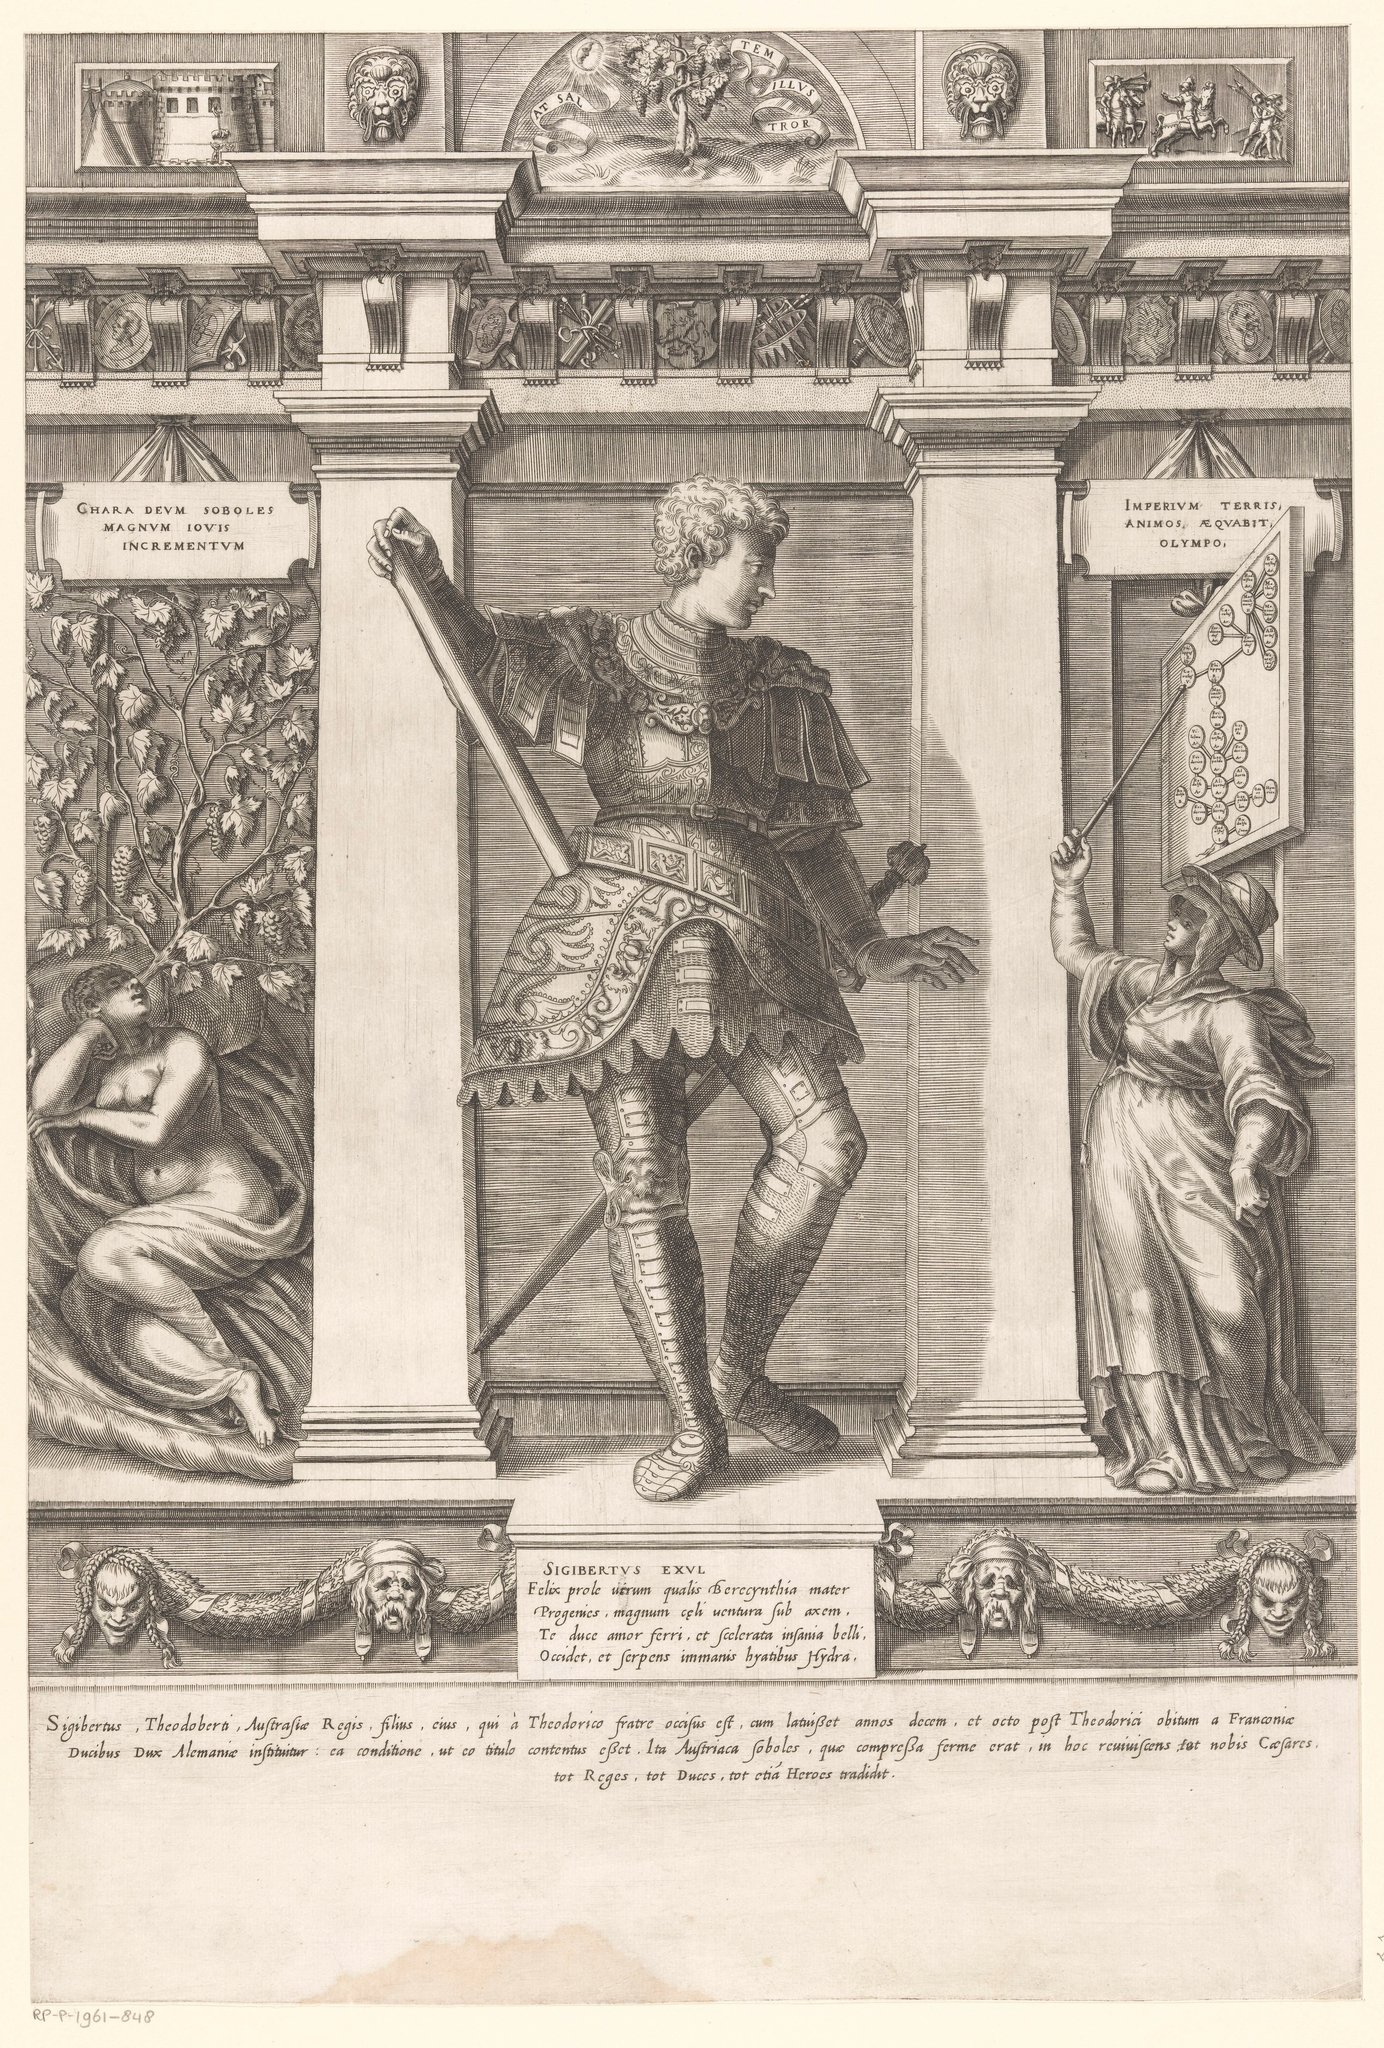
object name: print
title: Portret van Sigebert I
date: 1569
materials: paper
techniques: engraving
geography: italy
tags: historical persons, ruler, sovereign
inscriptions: collector's mark: Lugt 2228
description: Deze prent maakt deel uit van een reeks van 58 prenten. Het meerendeel van de prenten bevat portretten van 74 leden van het Oostenrijkse Huis, naar tekeningen door Francesco Terzio, die deels getekend zijn naar de 28 levensgrote bronzen beelden die rond de cenotaaf van Maximiliaan I in de Hofkirche te Innsbruck staan.